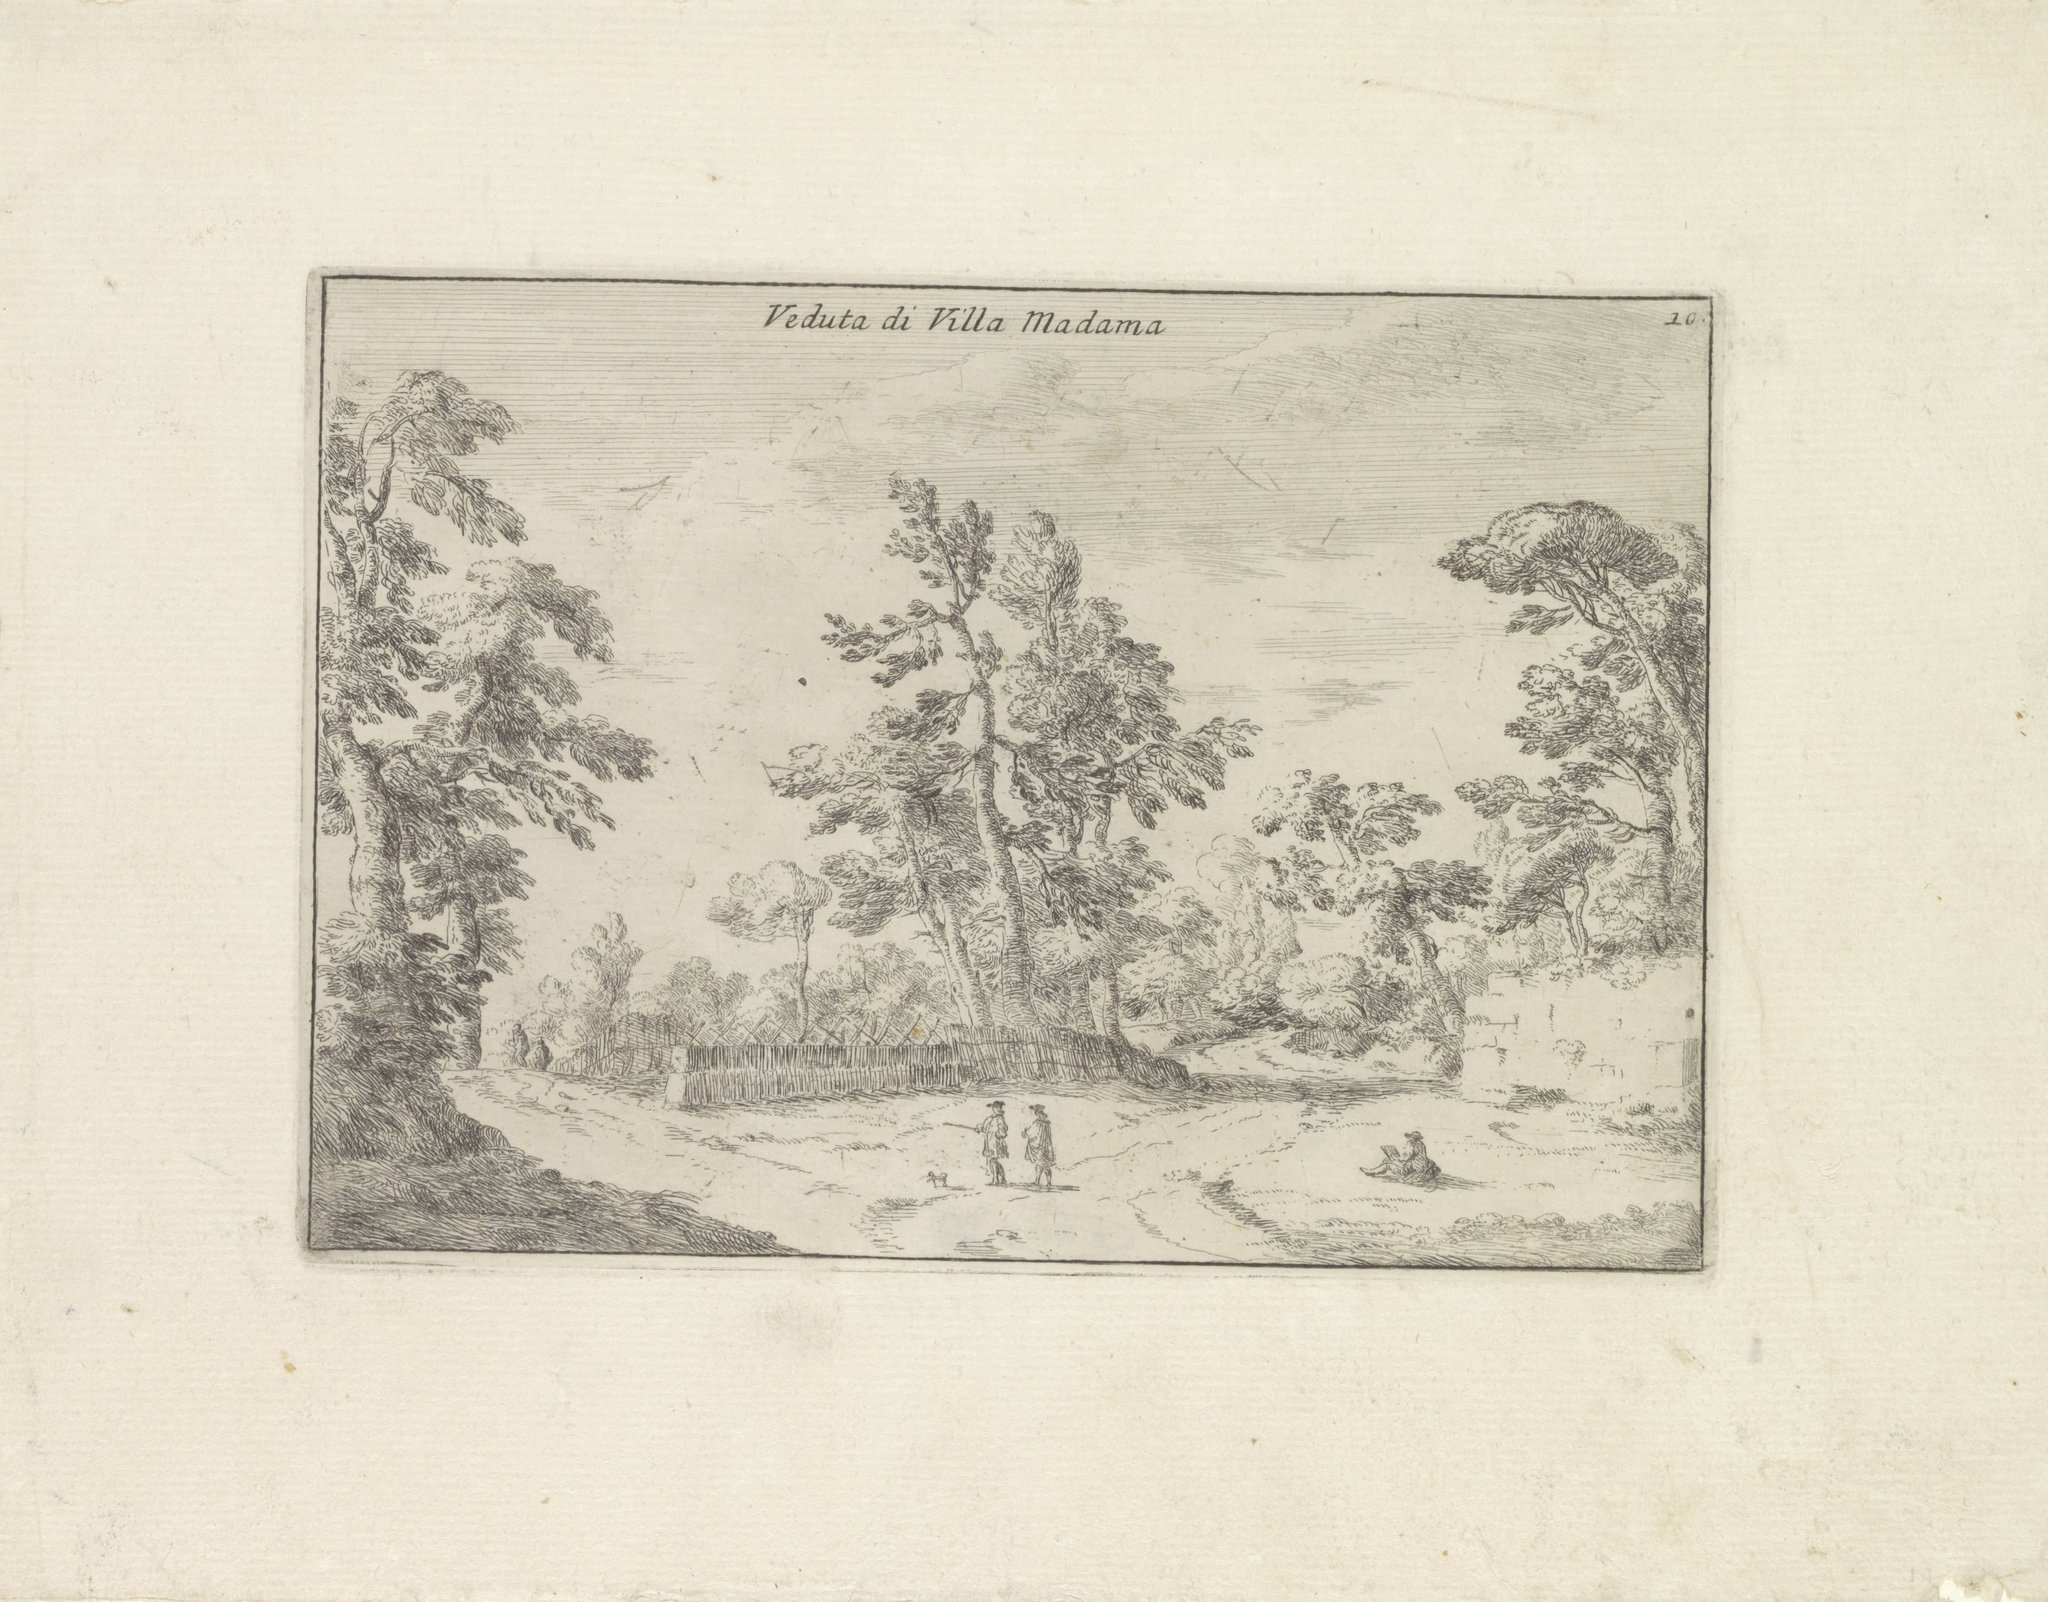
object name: print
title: Landschap nabij de Villa Madama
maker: paolo anesi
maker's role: print maker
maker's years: 1700-1761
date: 1725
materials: paper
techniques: etching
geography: rome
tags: landscapes, rome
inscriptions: collector's mark: Lugt 2760, collector's mark: Lugt 2228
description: Landschap nabij de Villa Madama in Rome. Rechts zit een man te tekenen. Midden boven de titel. Genummerd rechtsboven: 10.